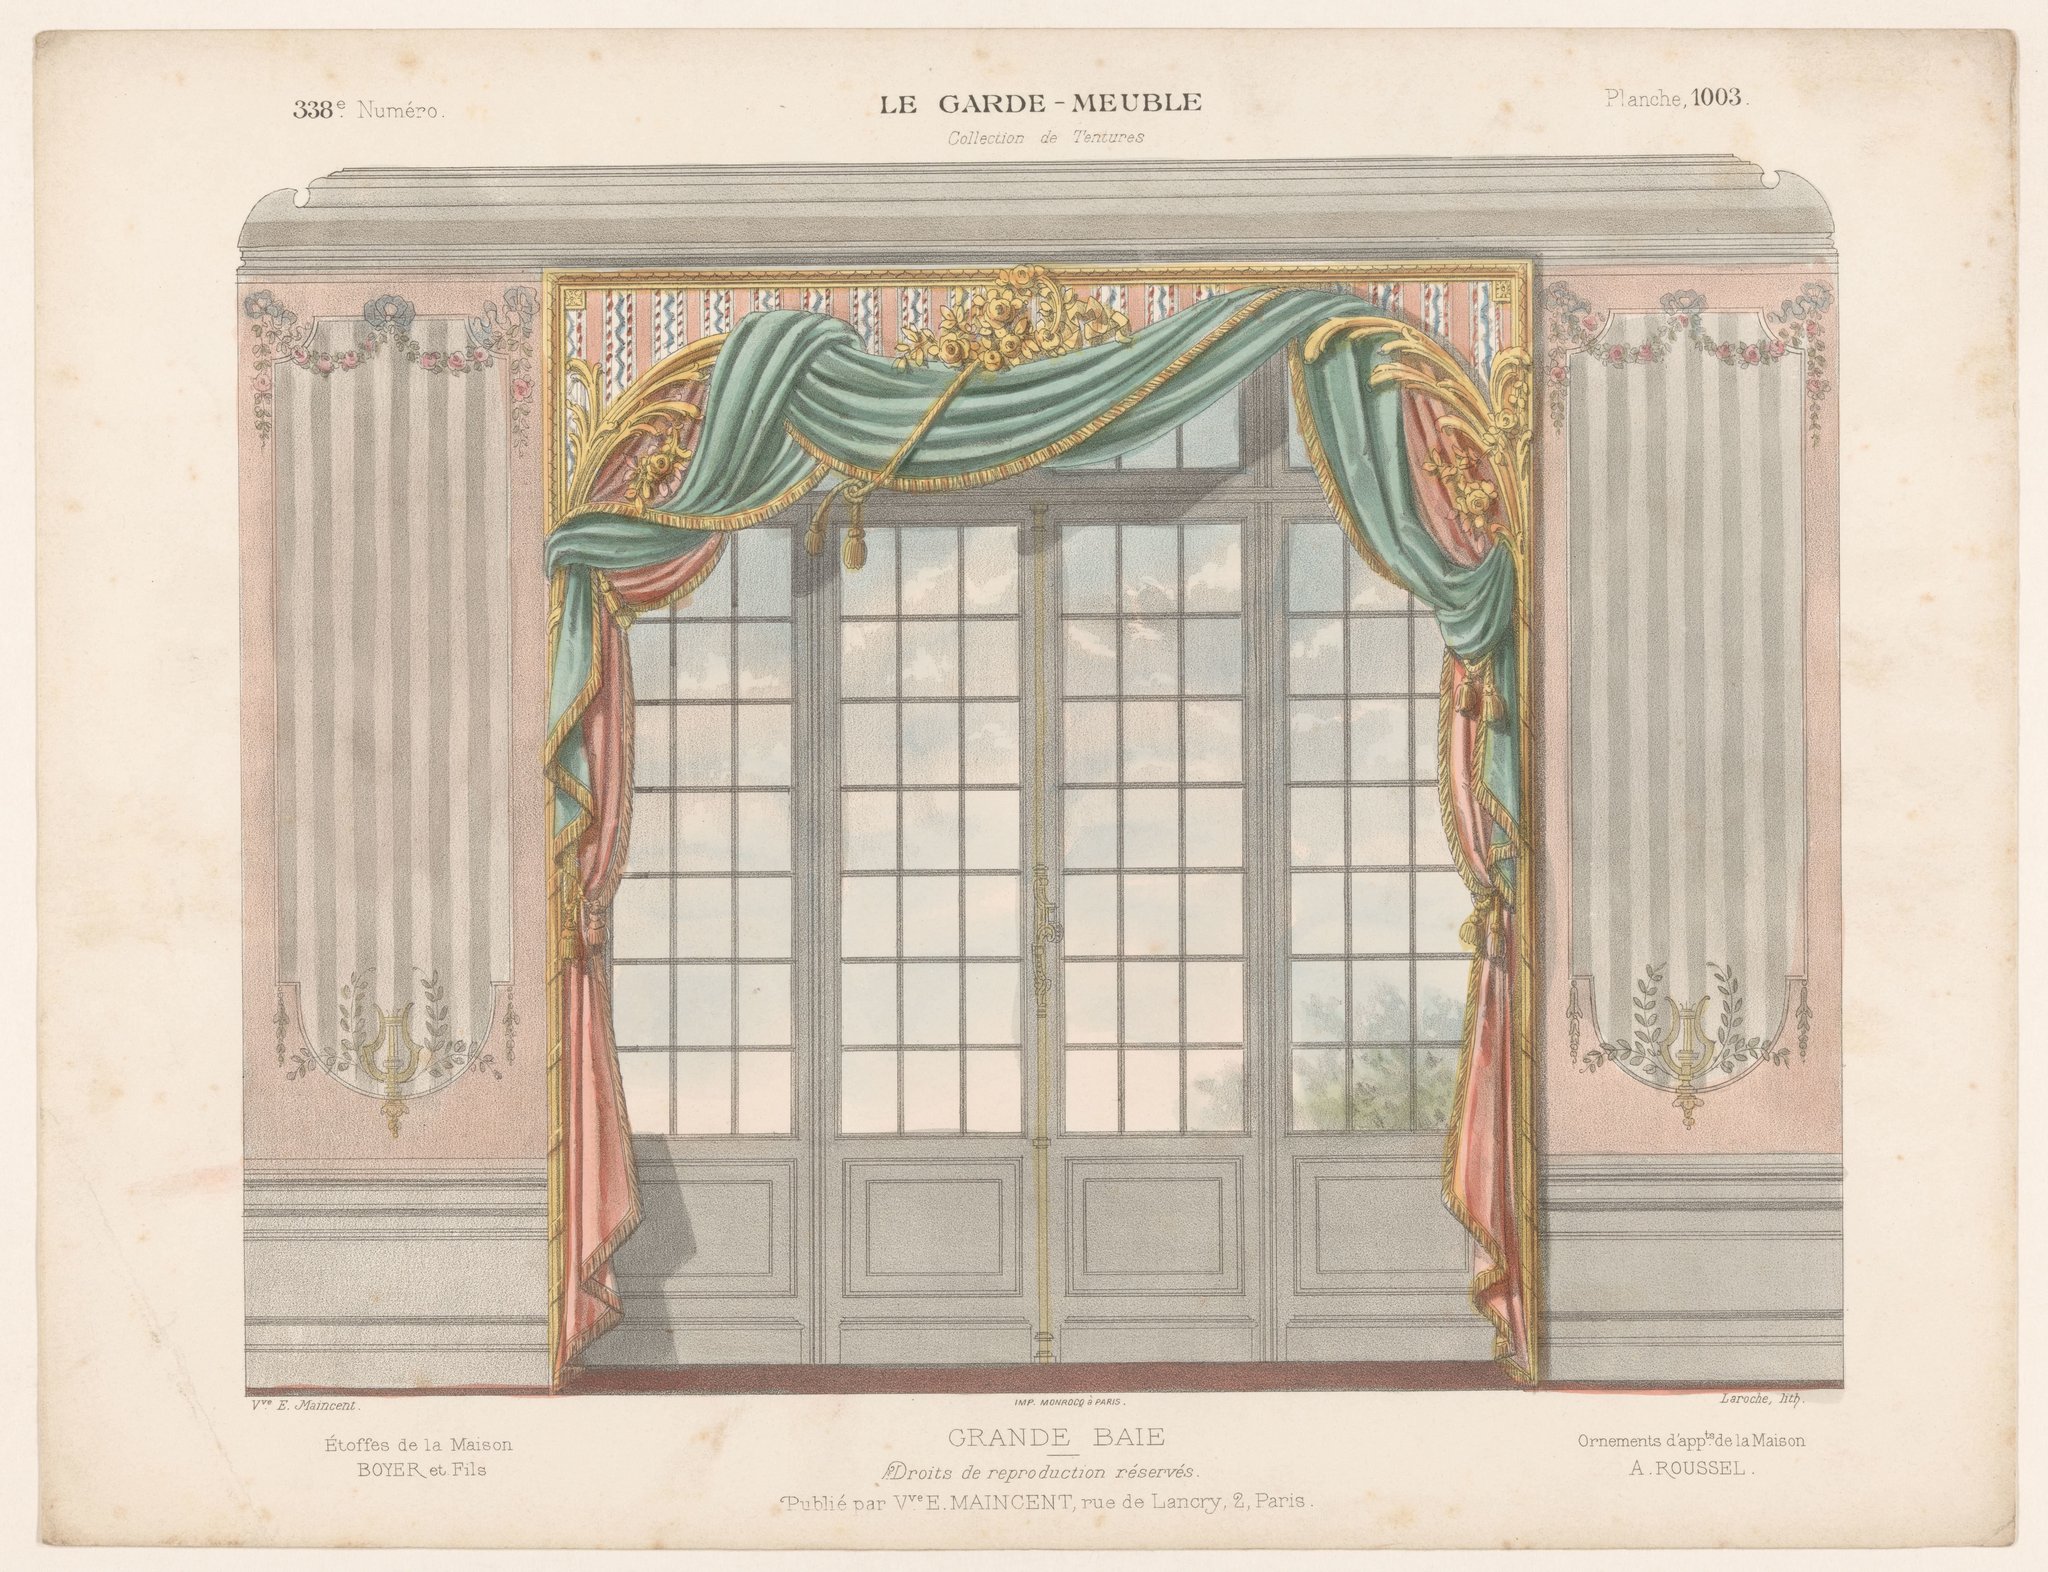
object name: print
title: Le Garde-Meuble / Collection de Tentures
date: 1895-1910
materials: paper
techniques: hand coloring, lithograph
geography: paris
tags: door, hangings and drapery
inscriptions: : ‘Droits de reproduction réservés.’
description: Grote doorgang met gedrapeerde gordijnen. Prent uit 338e Livraison.